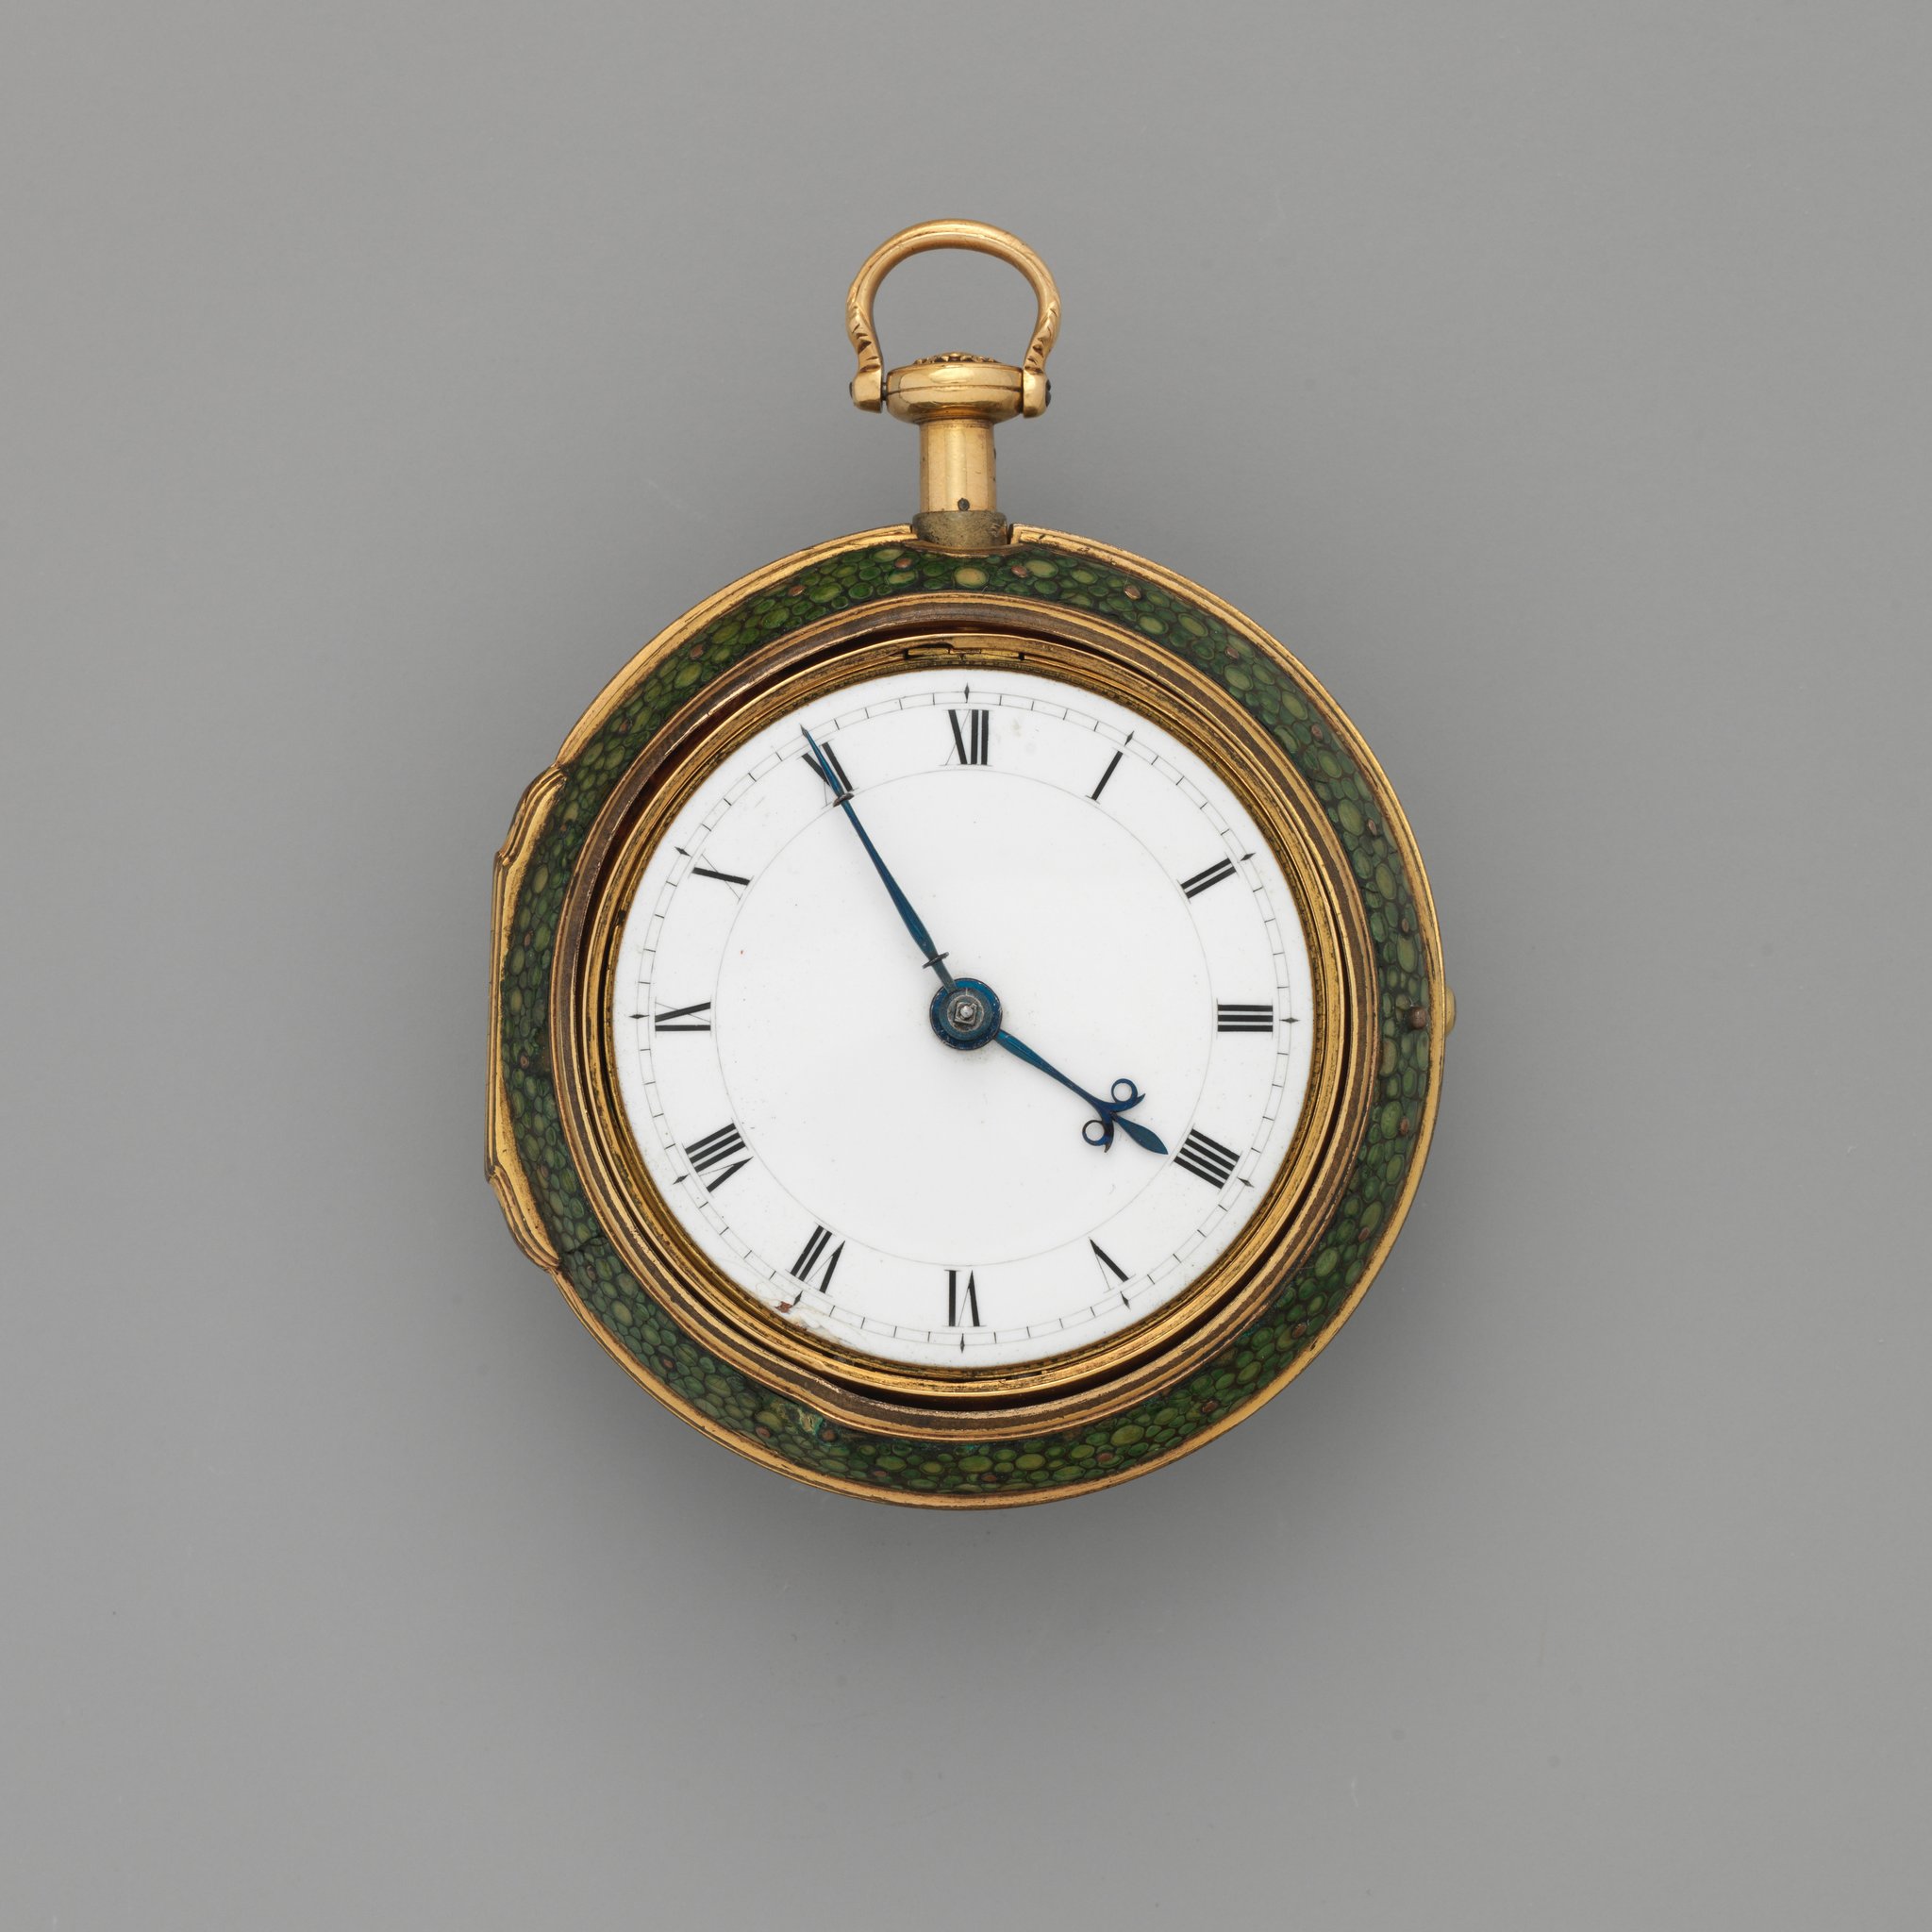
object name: quarter repeater watch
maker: william webster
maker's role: maker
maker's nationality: british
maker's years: 1635-1735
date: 1770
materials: enamel, gold